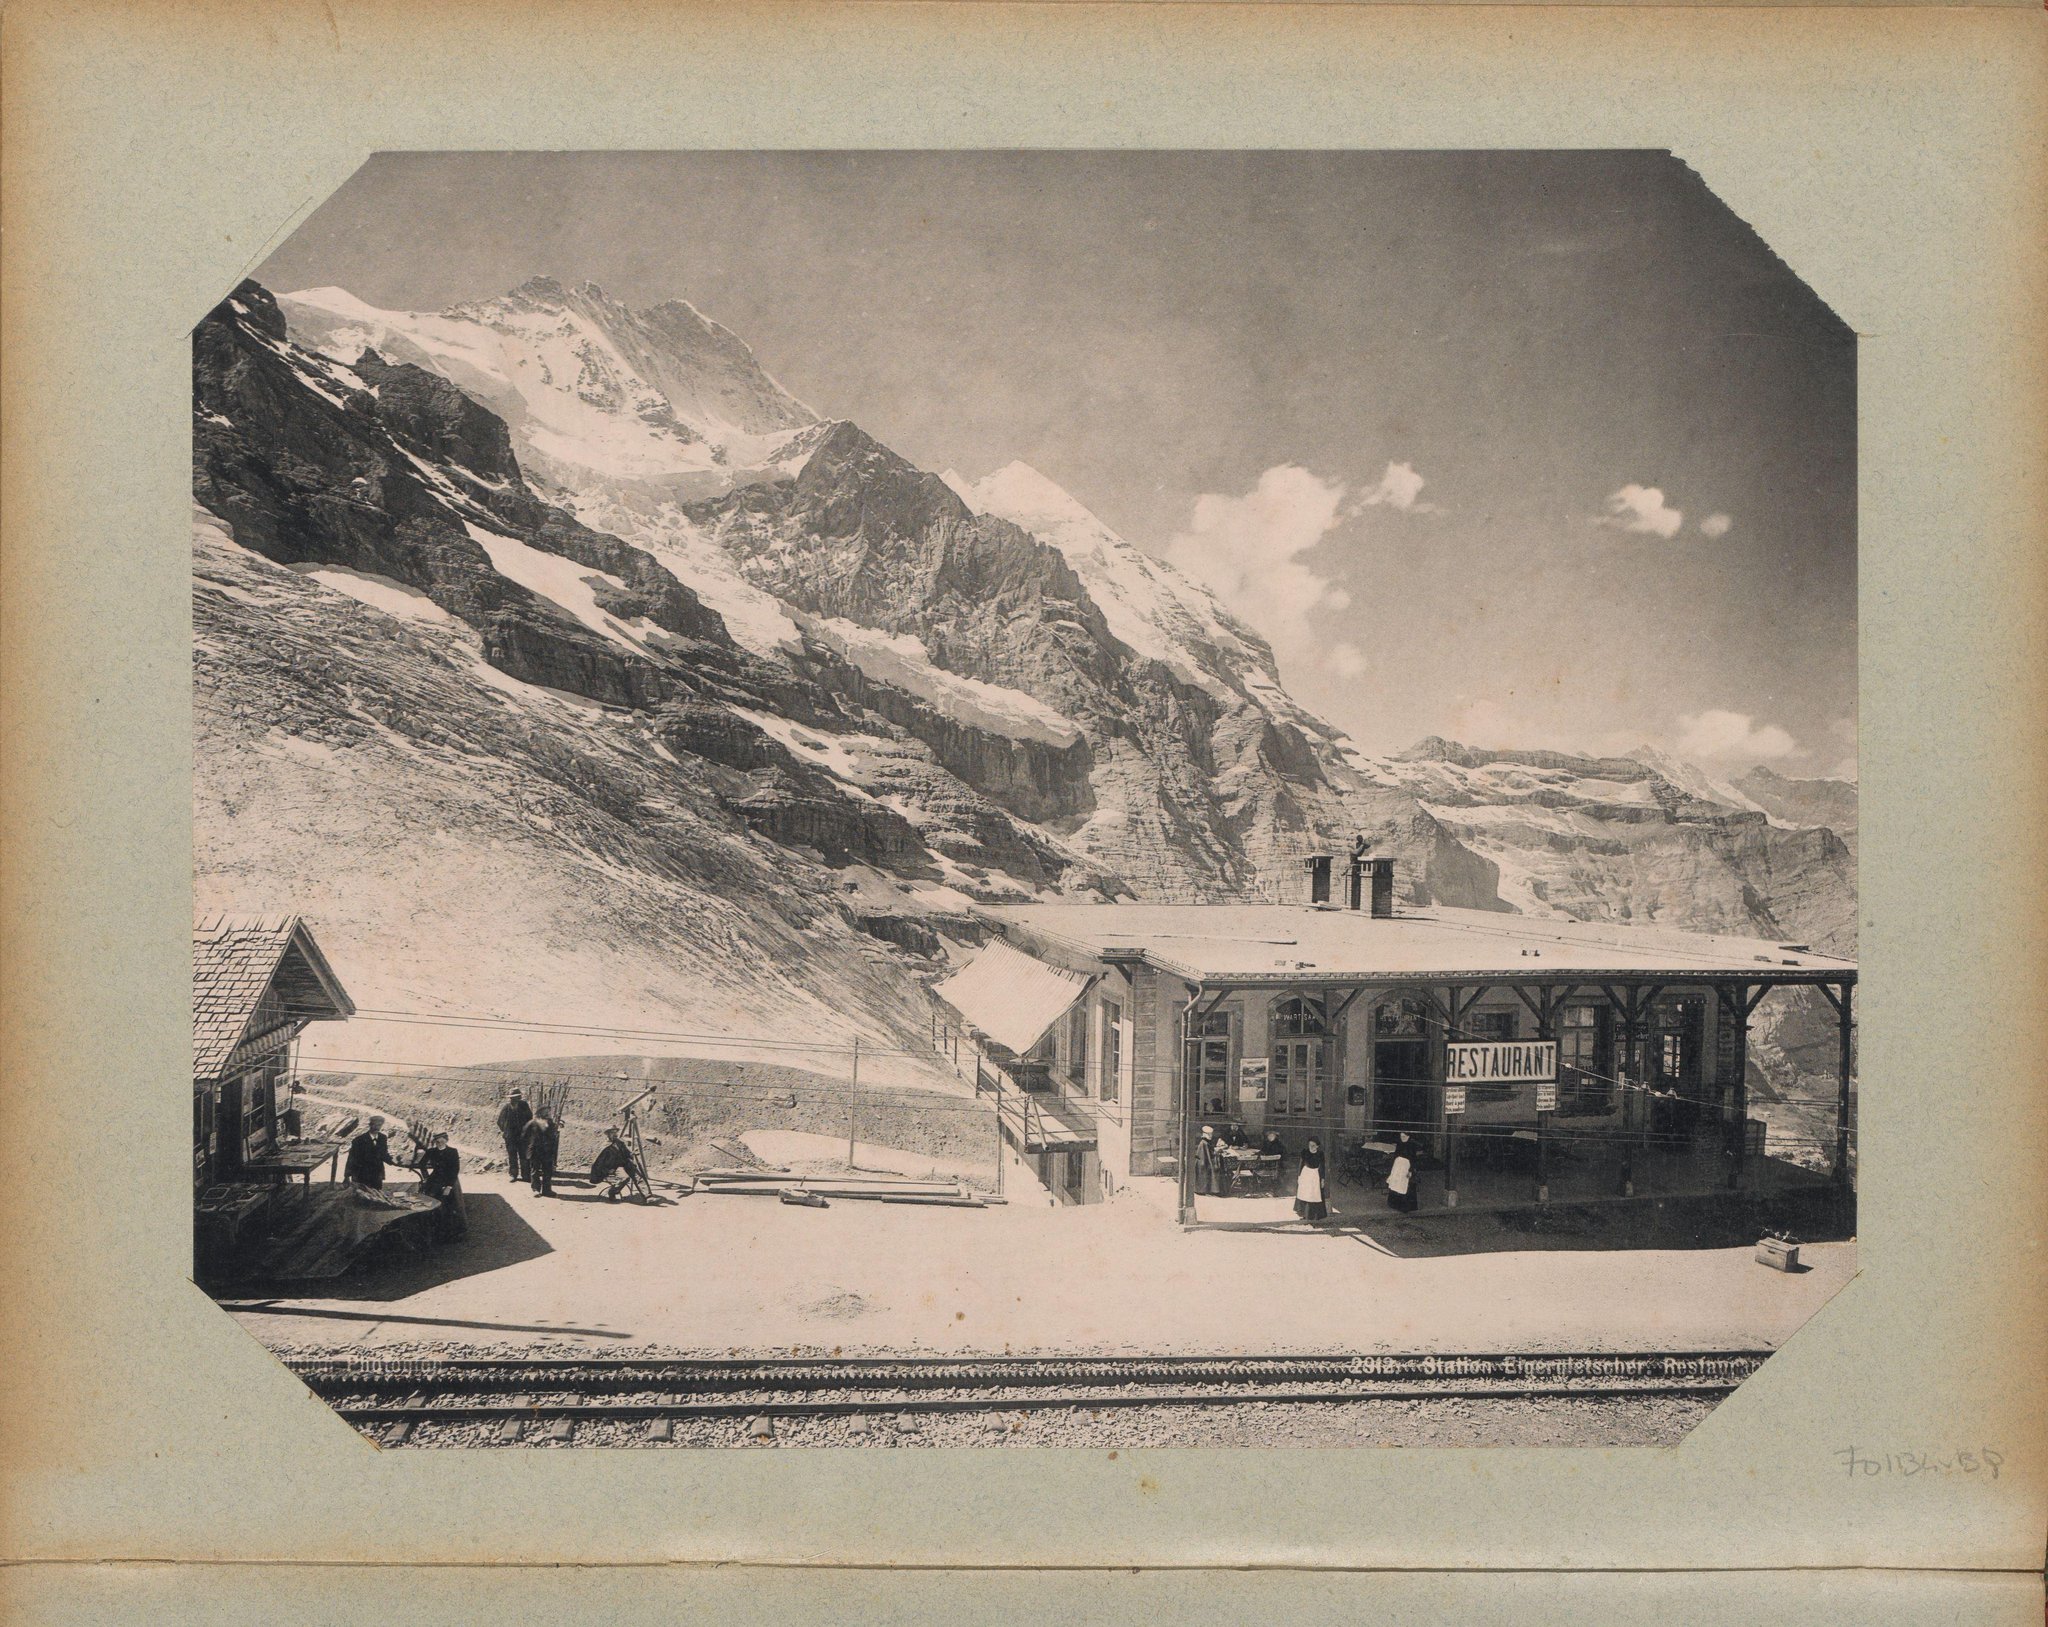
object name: album leaf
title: Station Eigergletscher Restaurant.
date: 1880-1910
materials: paper, photographic support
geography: lauterbrunnen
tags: restaurant (+ waiter, waitress, etc.), mountain-range, snow peaks, station; shelter (railway, tramway), binoculars, spy-glass, etc.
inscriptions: number: ‘2912’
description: Onderdeel van Reisalbum met bezienswaardigheden in Engeland, Zwitserland, Frankrijk en Duitsland.